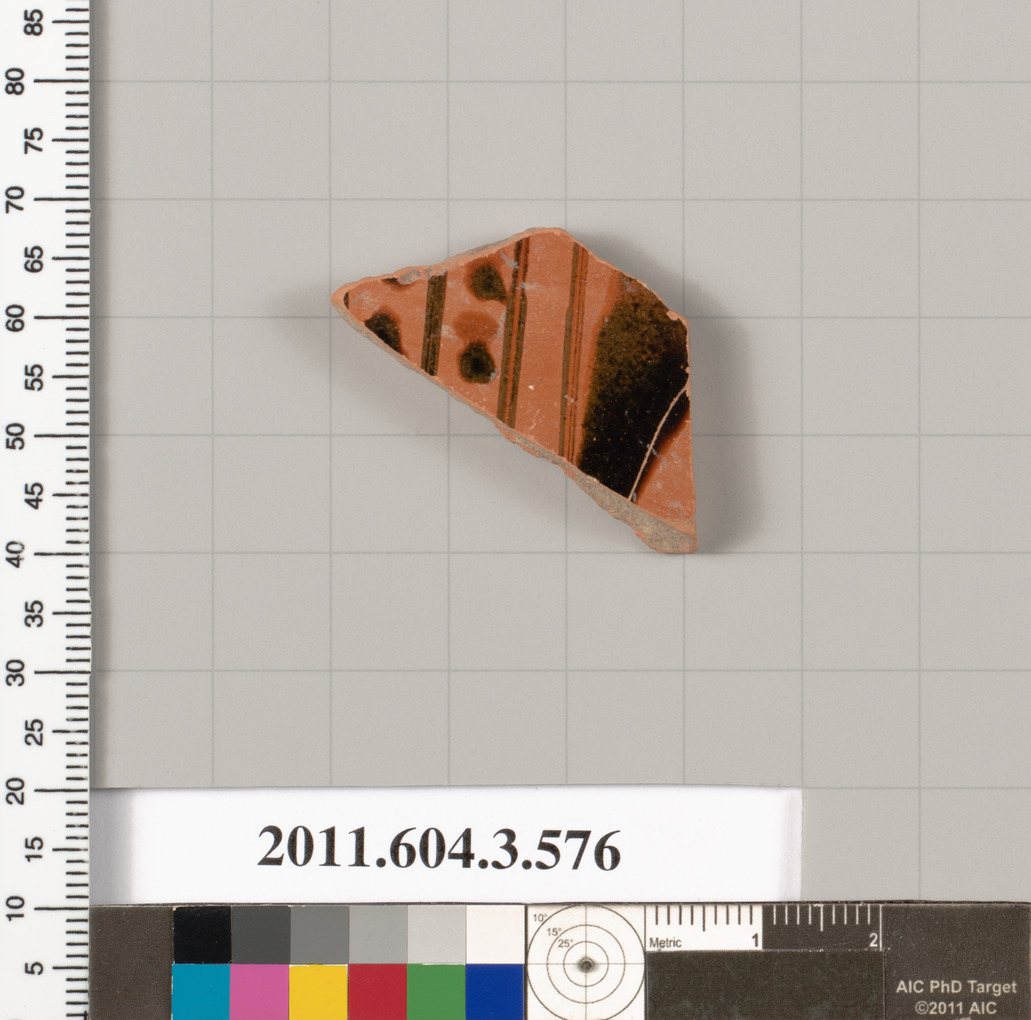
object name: column krater fragment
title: Terracotta fragment of a column-krater (bowl for mixing wine and water)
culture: greek, attic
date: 534-501 BCE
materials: terracotta